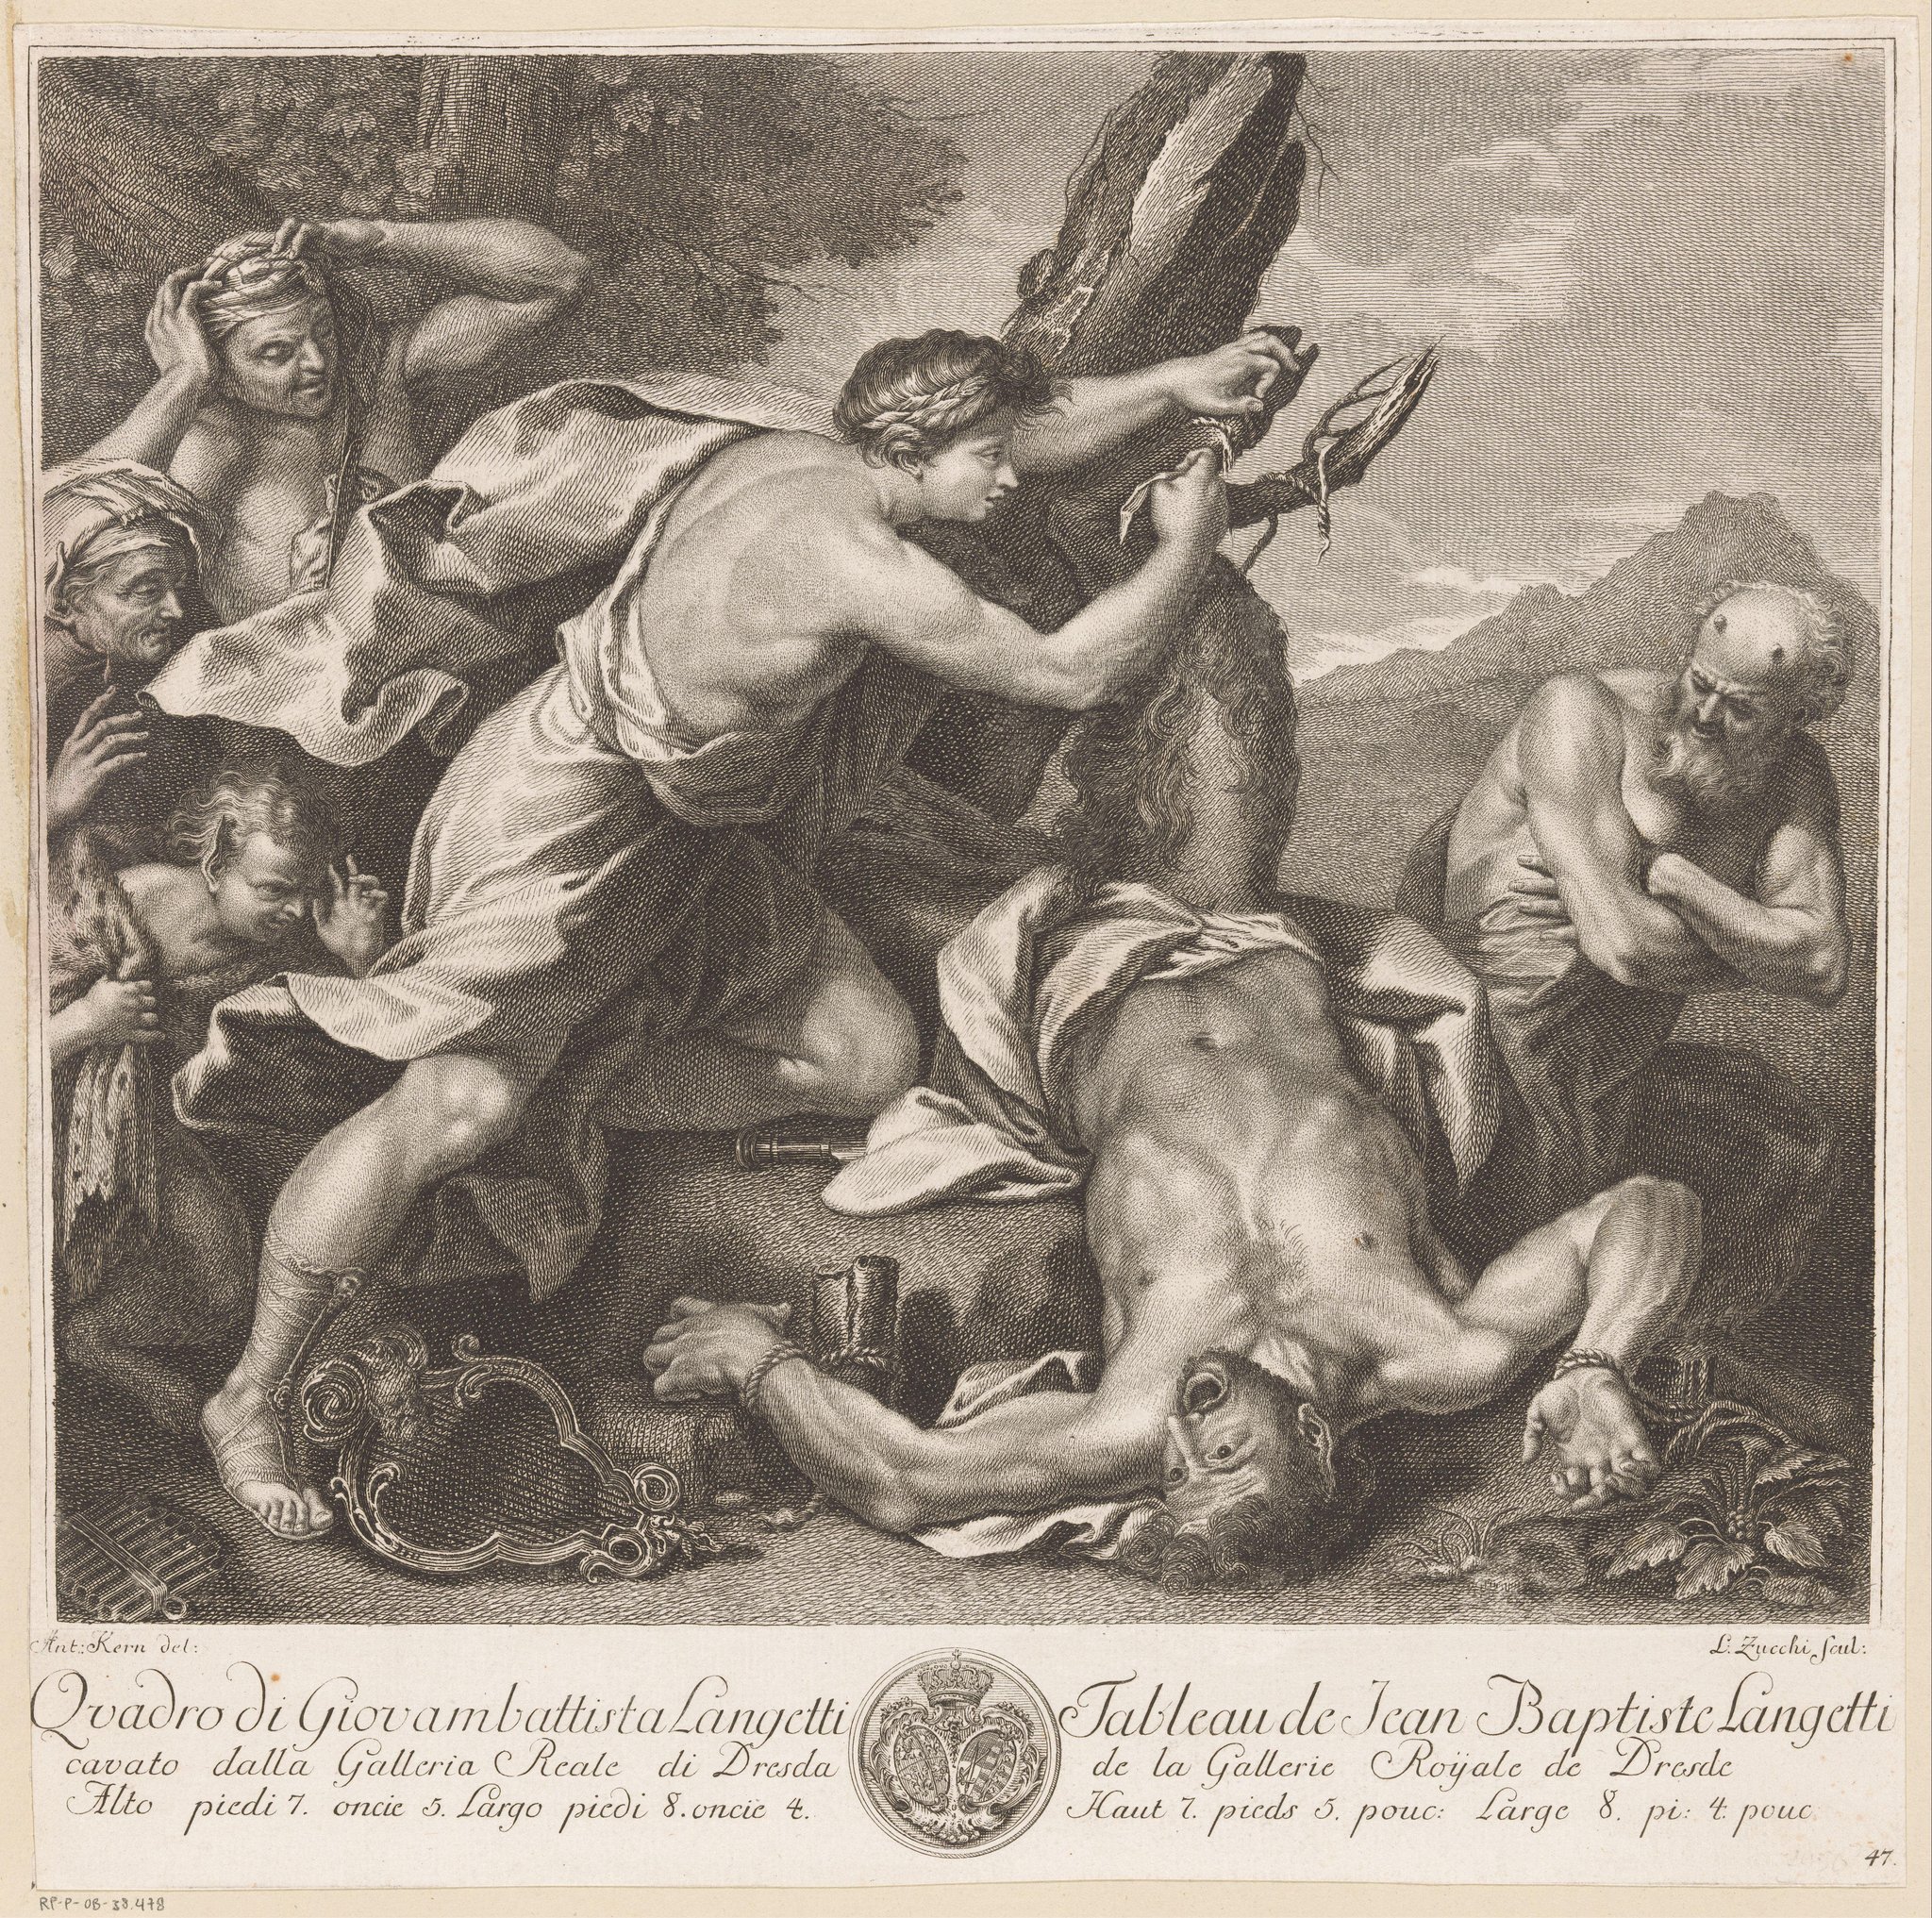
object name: print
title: Apollo bindt Marsyas aan een boom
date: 1714-1779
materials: paper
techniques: engraving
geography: italy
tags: satyr(s) (in general), punishment of marsyas: he is flayed by apollo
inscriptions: collector's mark: Lugt 240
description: Na zijn verlies in een muziekwedstrijd wordt de sater Marsyas door Apollo aan een boom gebonden. Vier andere saters kijken toe. Links op de voorgrond ligt de panfluit van Marsyas. Italiaanse en Franse tekst in ondermarge. Genummerd rechtsonder: 47.